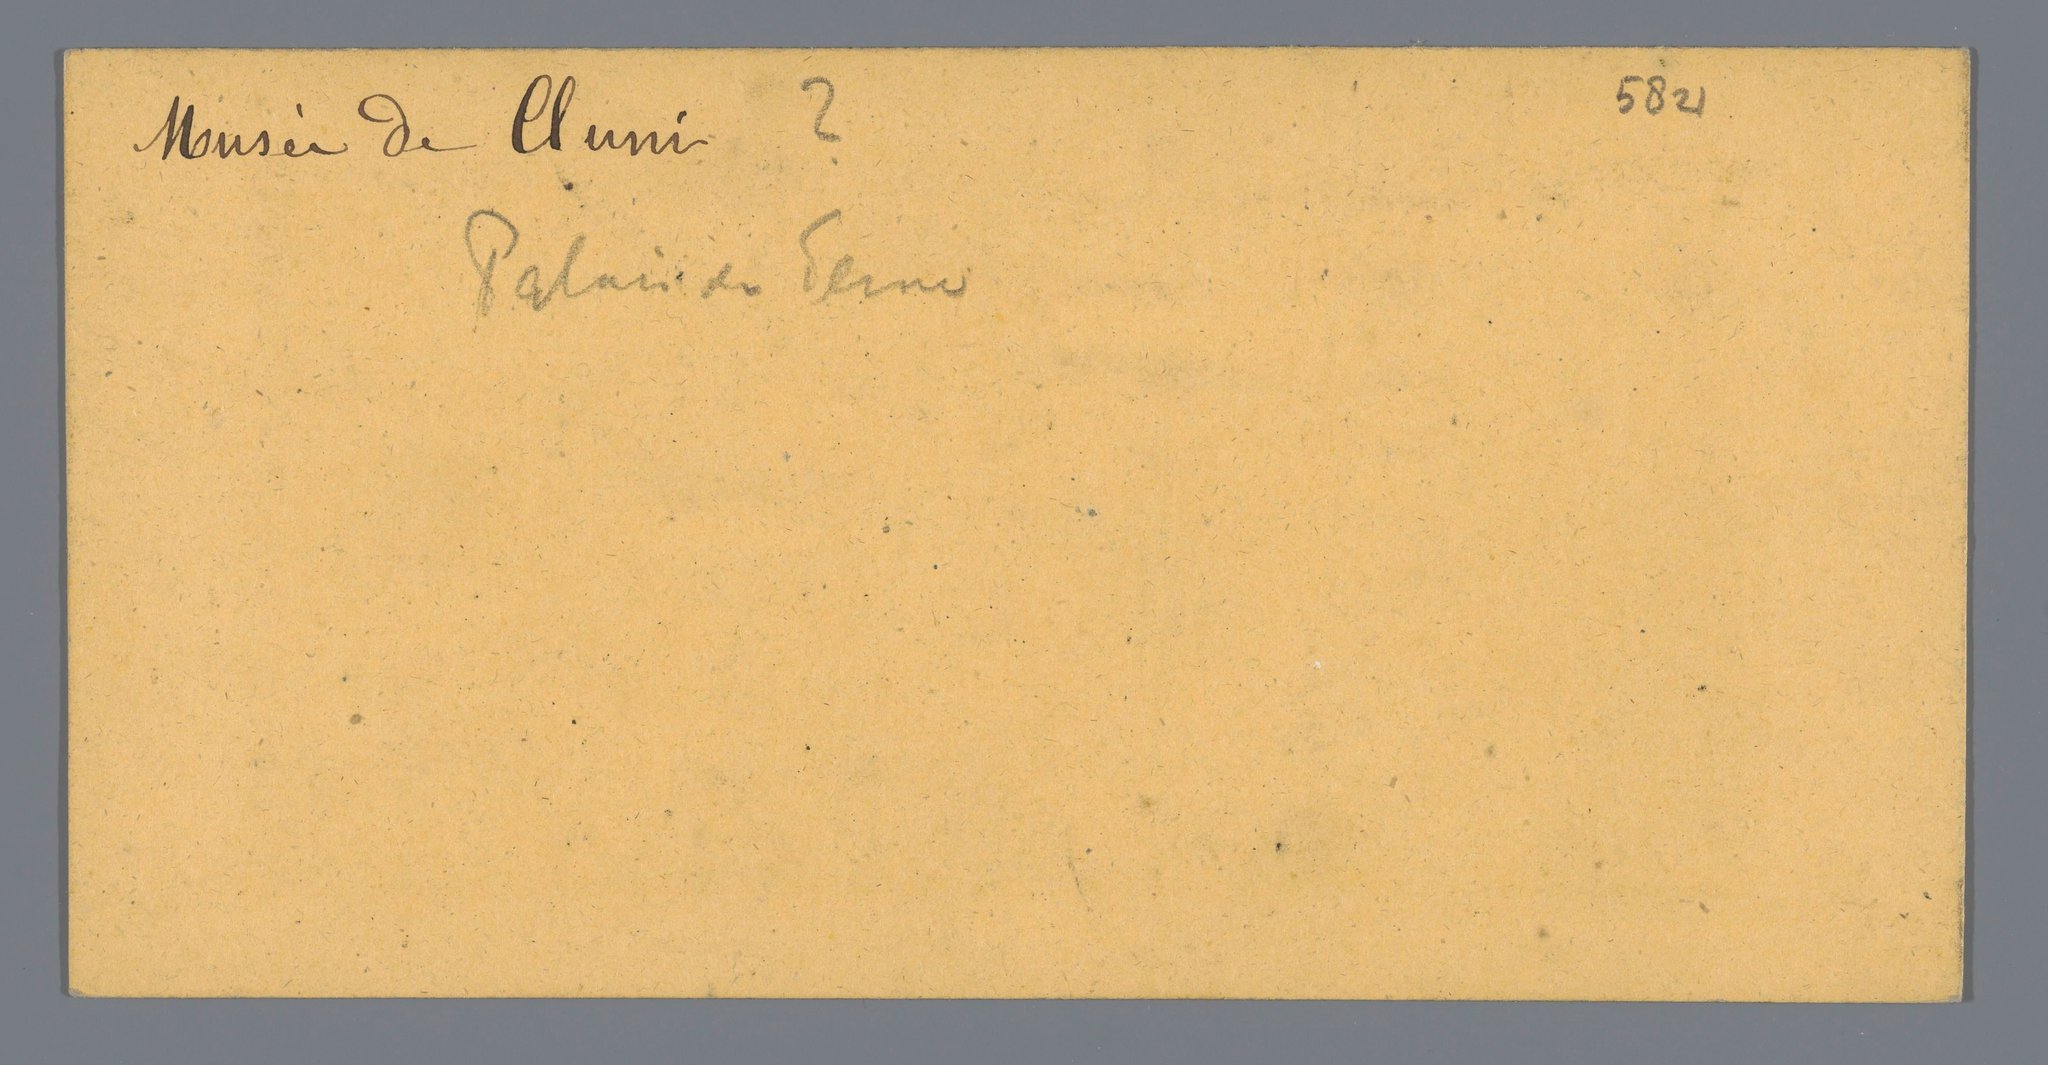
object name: stereograph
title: Gezicht op de Thermes de Cluny in Parijs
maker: Anonymous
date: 1850-1880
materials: cardboard, photographic support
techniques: albumen print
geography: paris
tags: public baths, ruin of a dwelling, house, castle, etc.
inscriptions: inscription: ‘Musée de Cluni? Palais de Terme’